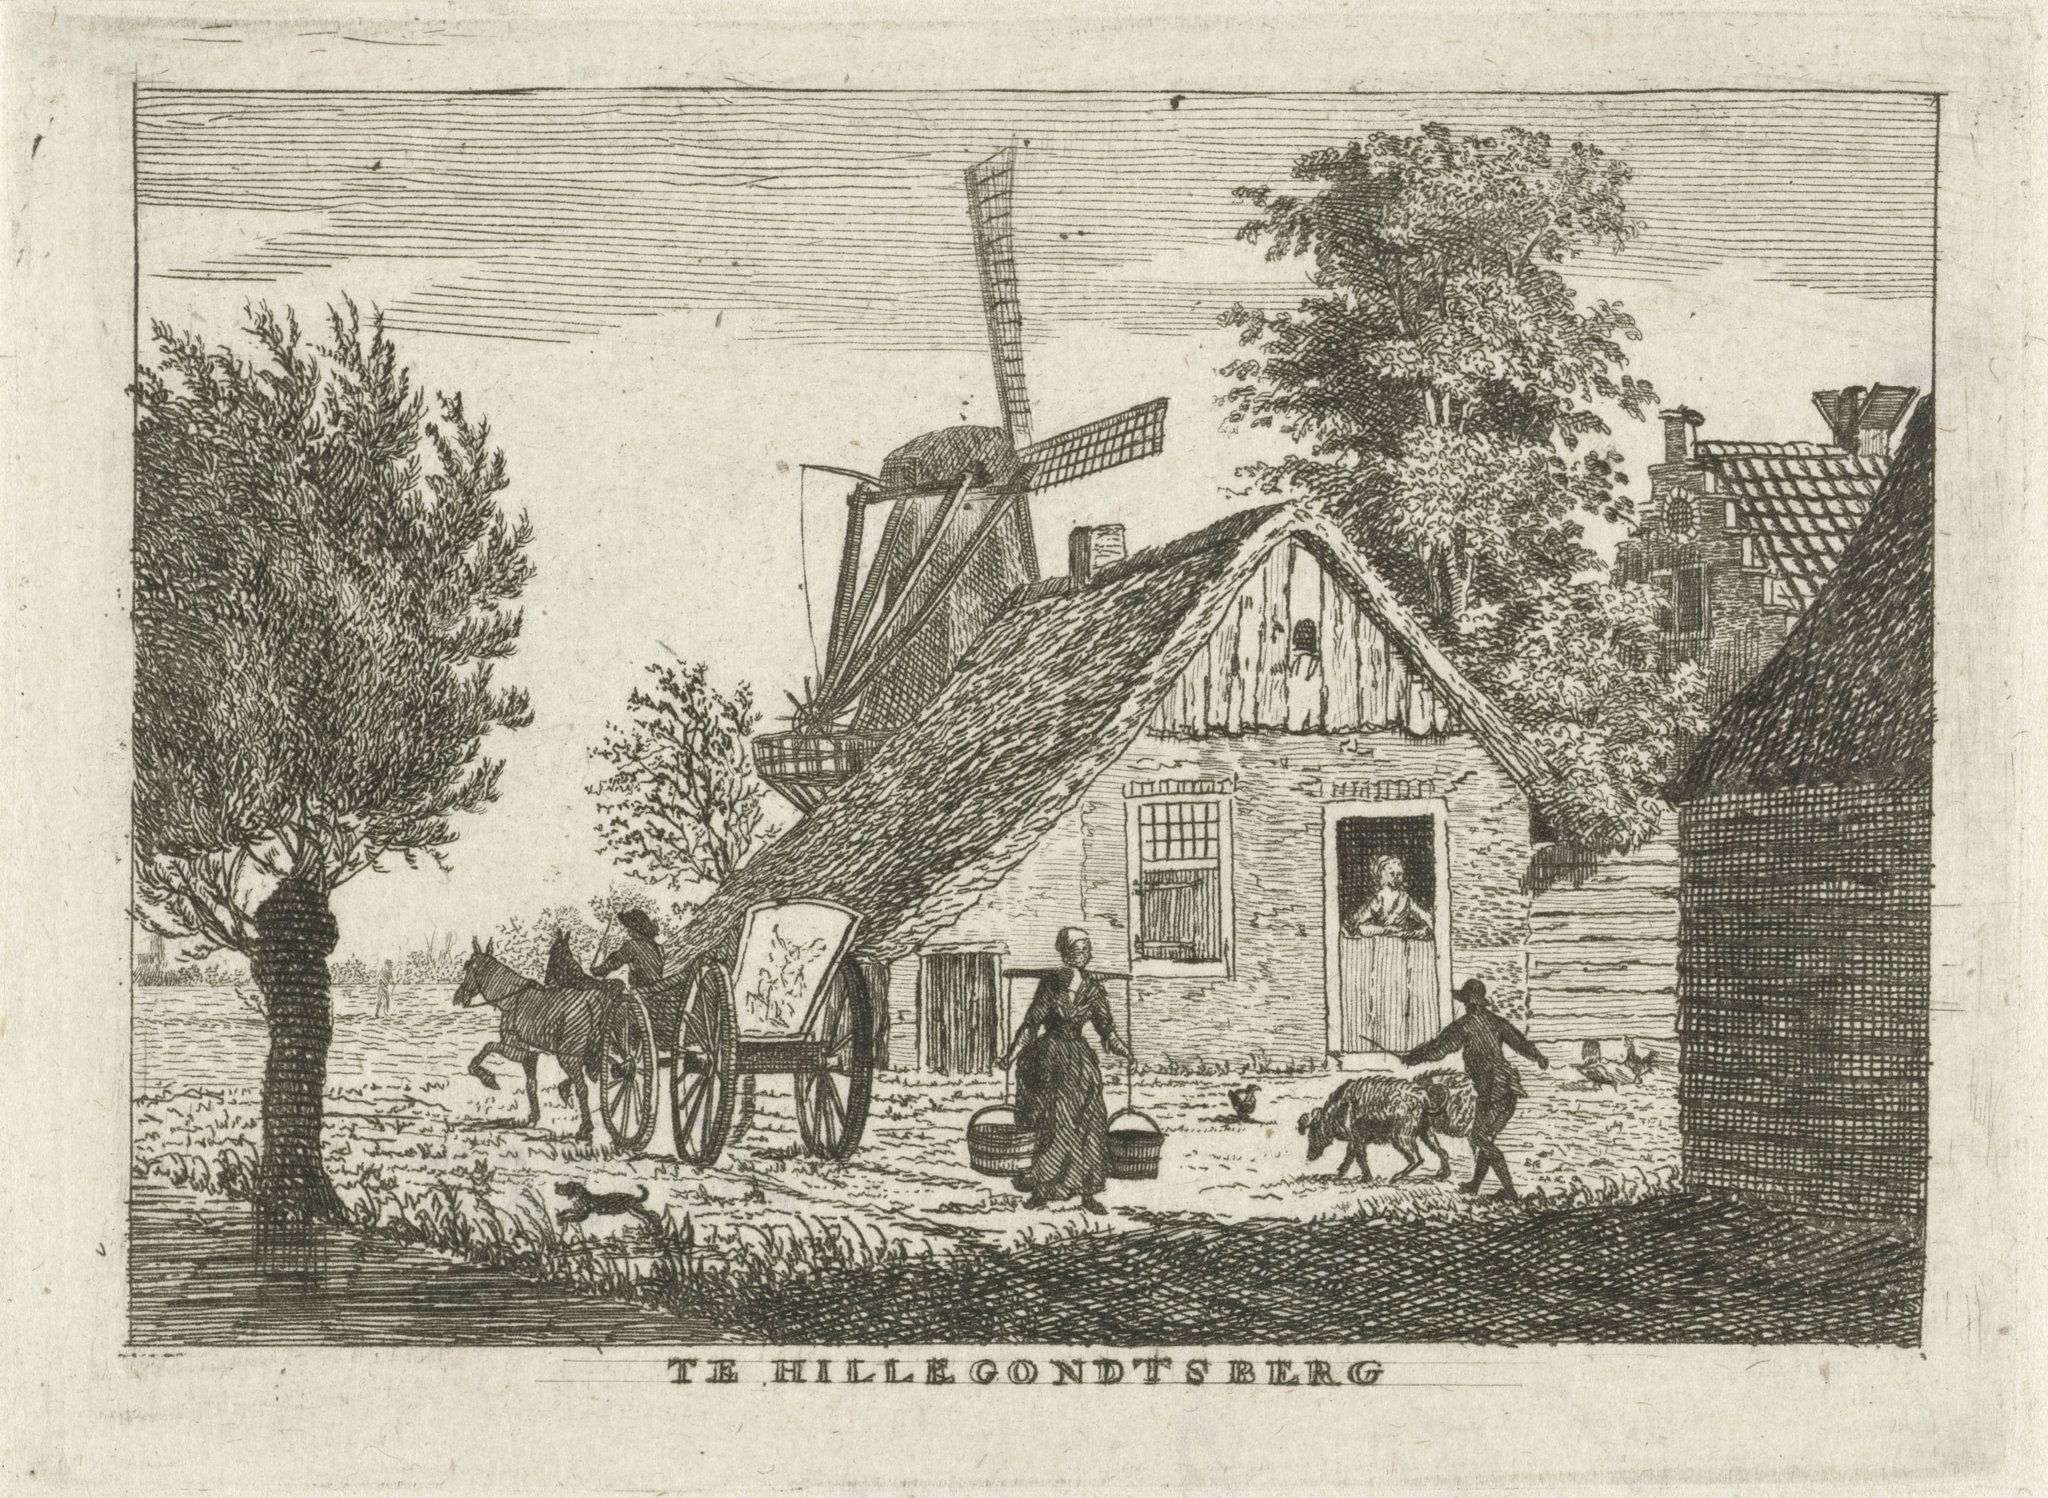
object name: print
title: Te Hillegondtsberg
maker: hendrik roosing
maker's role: print maker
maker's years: 1763-1826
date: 1780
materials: paper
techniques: etching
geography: rotterdam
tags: pig, canals, waters (in village), village, fowl (cock, hen, chicken, etc.), dog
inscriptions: collector's mark: Lugt 2228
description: Gezicht aan de rand van een dorp met links een vaart en rechts een dorpsweg met huizen en een molen. Op de weg een koets, een vrouw met melkemmers, kippen en een man die twee biggen voort drijft.